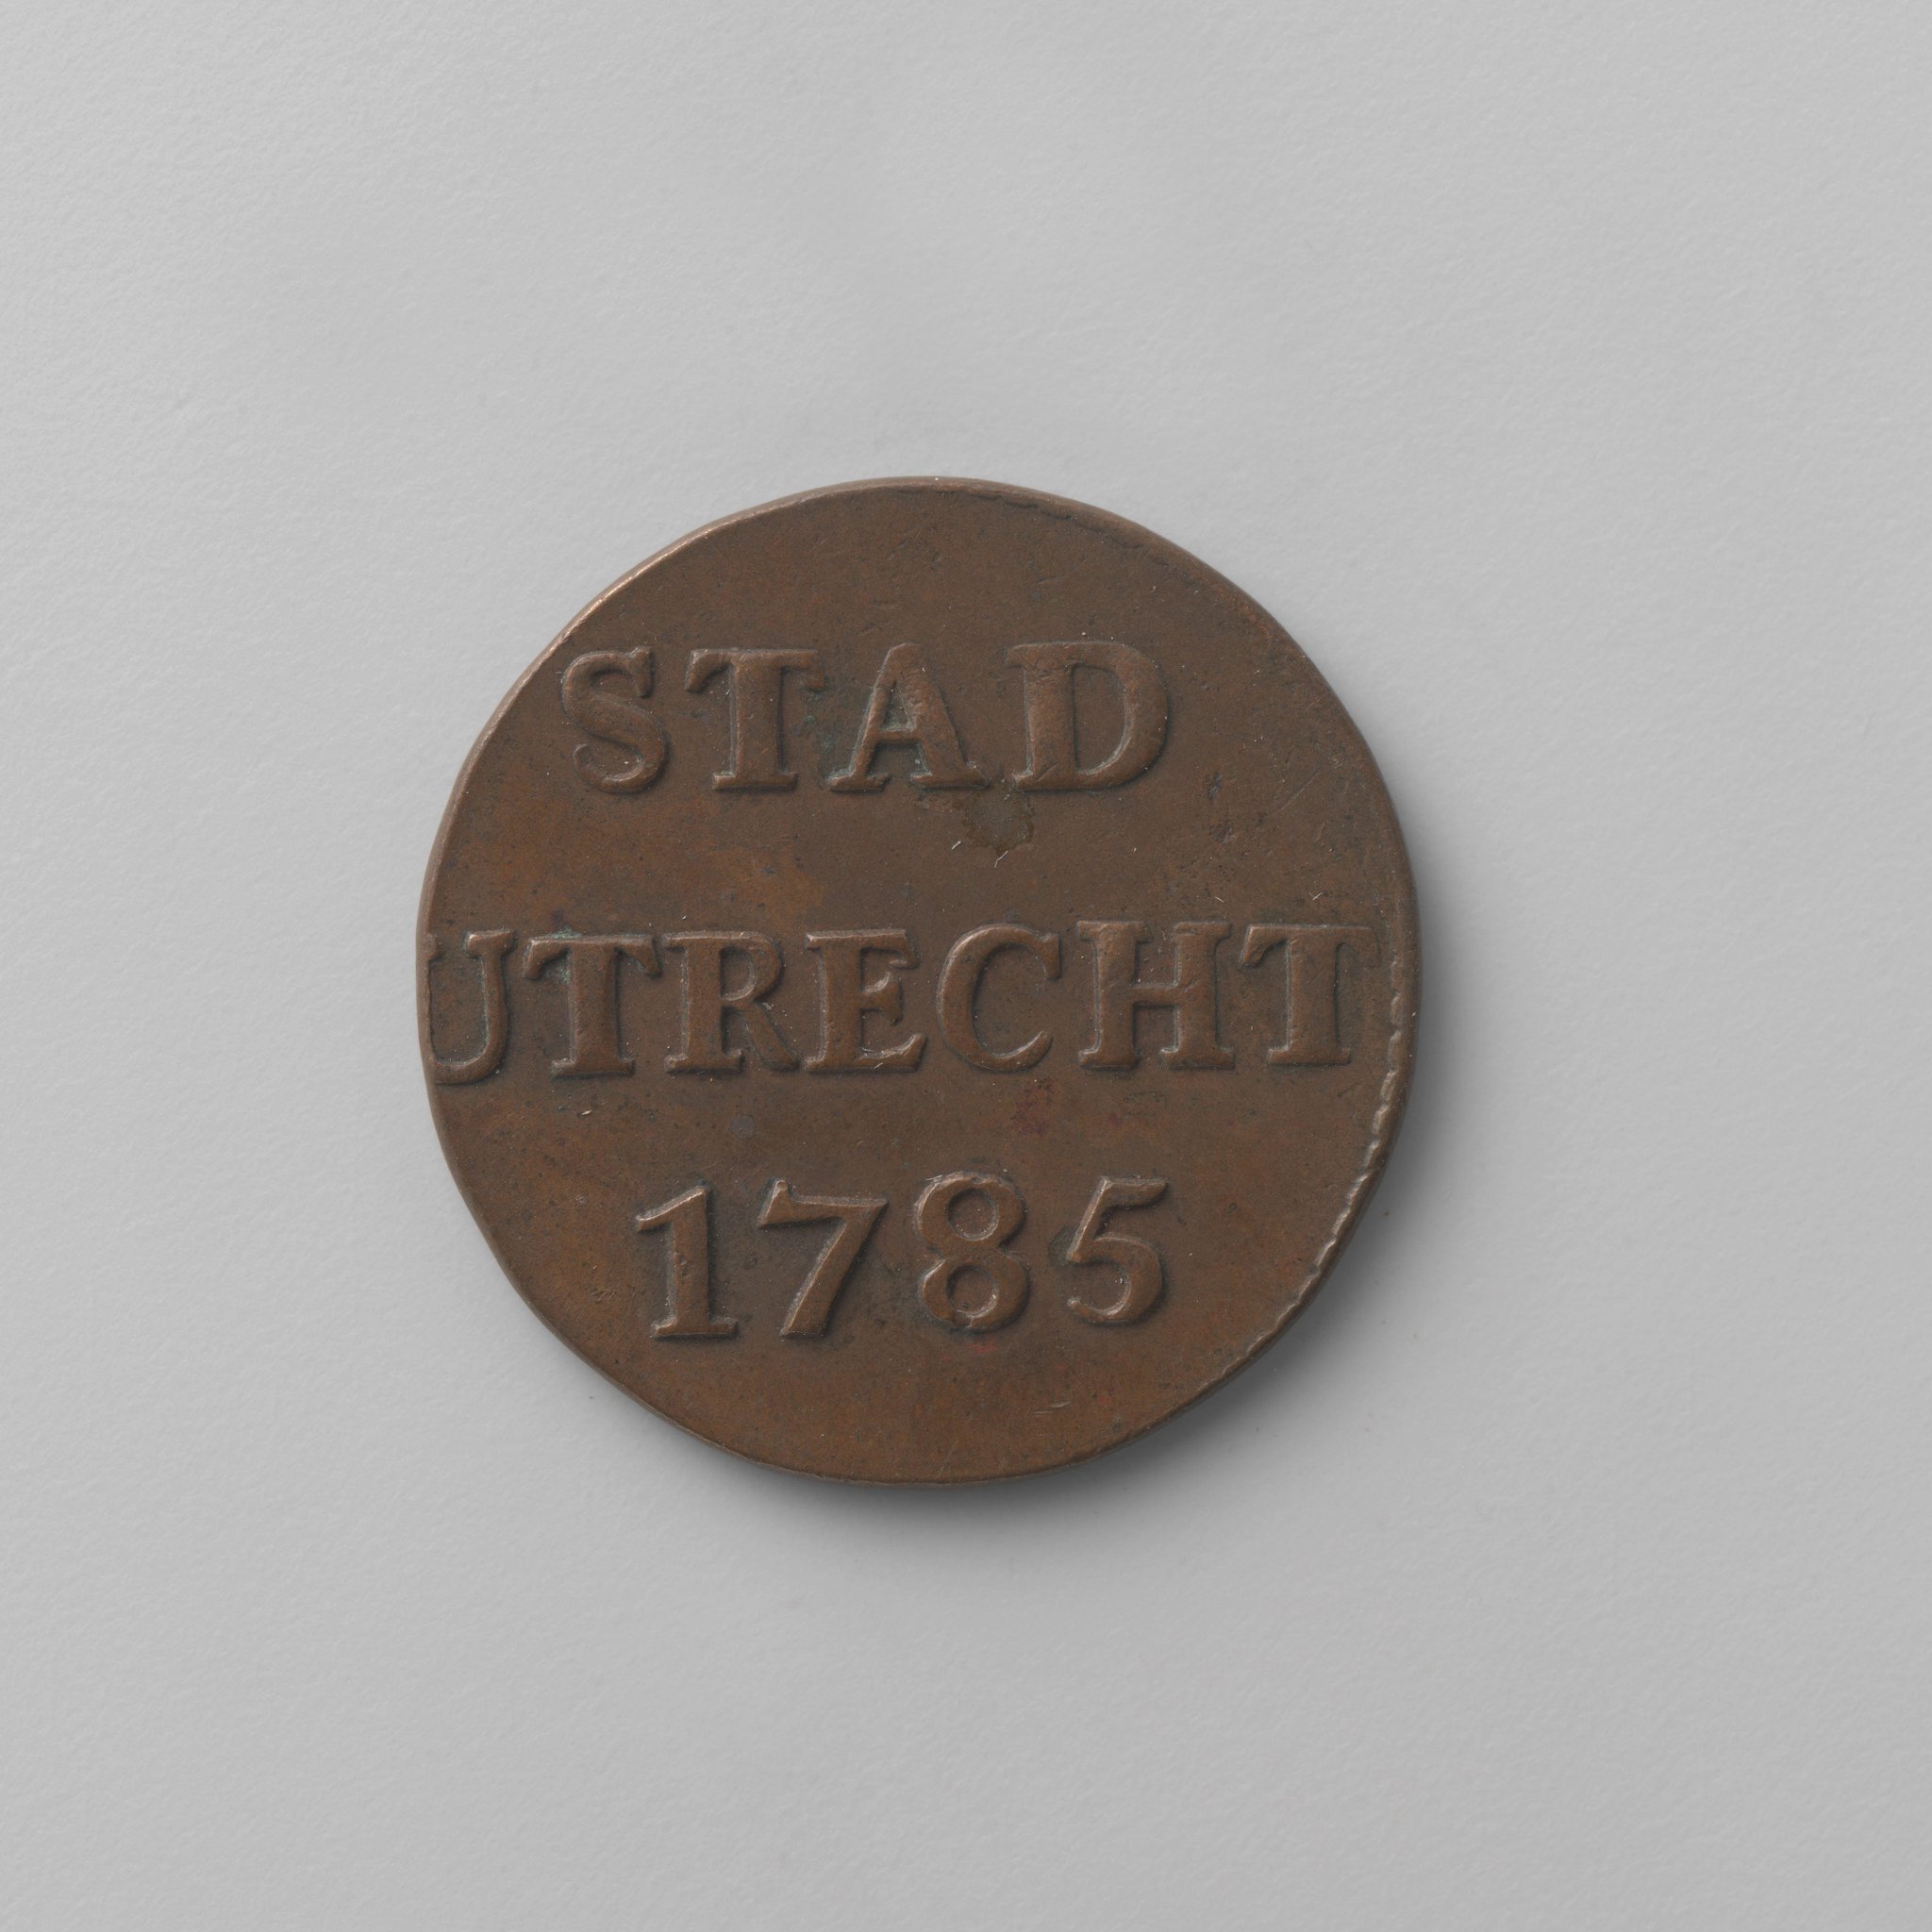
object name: coin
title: Stad Utrecht, duit, 1785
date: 1785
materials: copper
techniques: striking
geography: utrecht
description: Koperen munt. Voorzijde: gekroond stedelijk wapenschild, gehouden door twee leeuwen met in afsnede dubbele lijn, waaronder een versierde accolade met een grote schelp. Keerzijde: opschrift in twee regels, waaronder jaartal. Jaartal met Arabische 1.